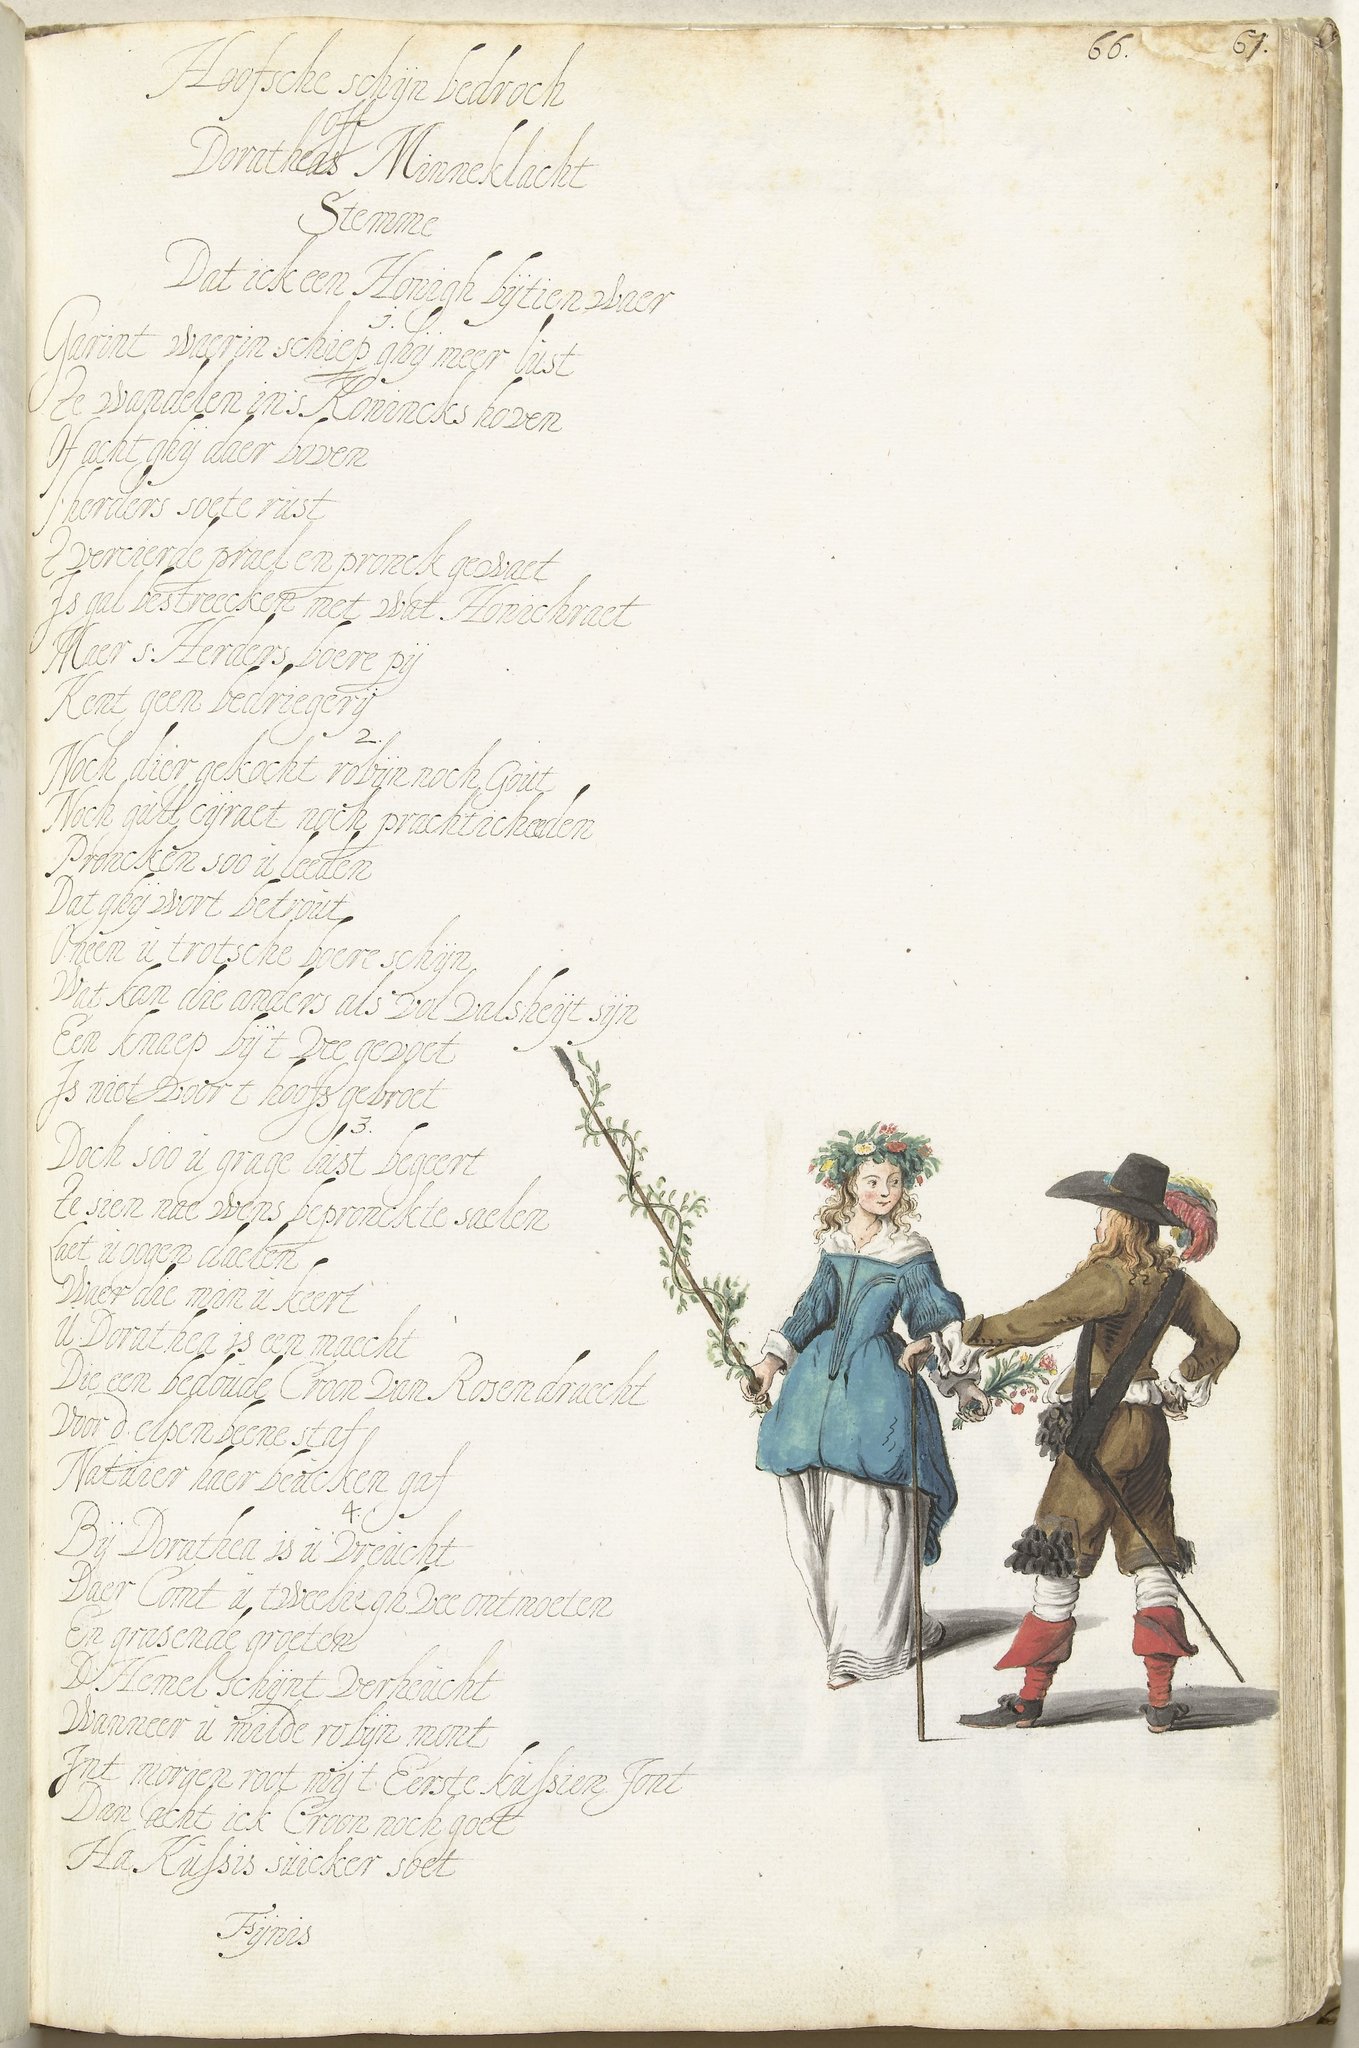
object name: calligraphy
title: Heer en herderin in gesprek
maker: gesina ter borch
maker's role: draughtsman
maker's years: 1633-1690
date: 1654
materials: ink, paper, watercolor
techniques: brush, calligraphy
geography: zwolle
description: Heer en herderin in gesprek naast gedicht op de melodie van Dat ick een honigh bijtien waer. In het gedicht vraagt de spreekster, Dorathea, aan haar geliefde Garint wat beter is: de rijkdom van het hof of de zoete rust van het herdersleven.